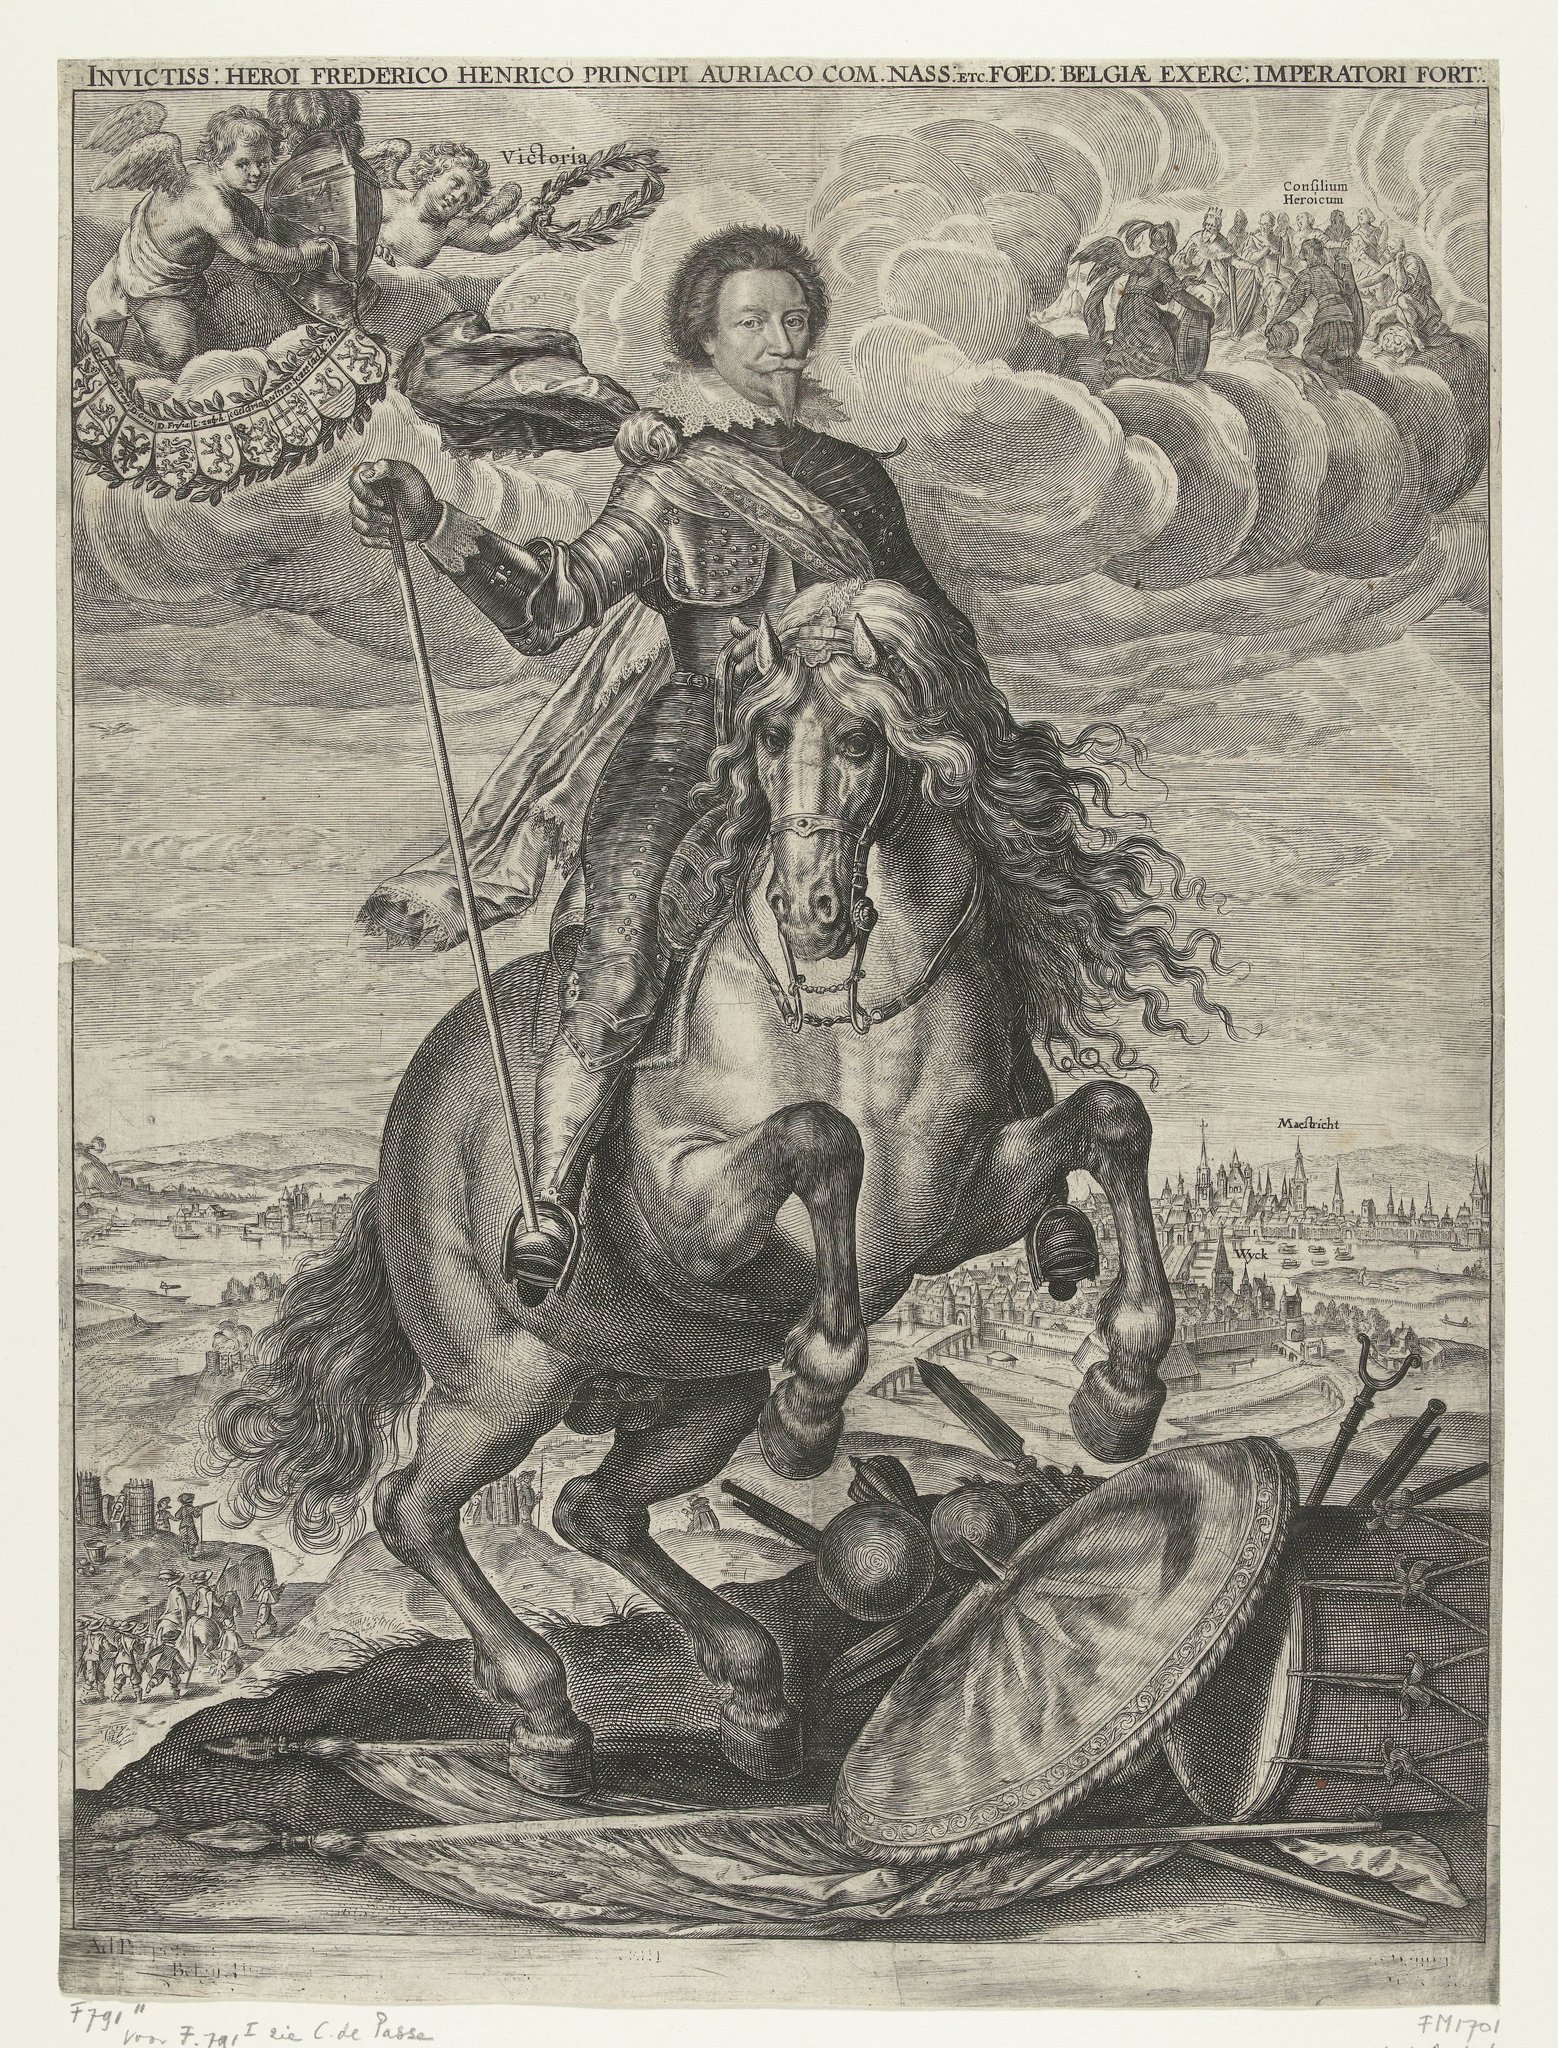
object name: propagandaprent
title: Invictiss: Heroi Frederico Henrico Principi Auriaco Com. Nass. etc. Foed. Belgiae Exerc. Imperatori Fort.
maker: crispijn van de passe (i)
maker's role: draughtsman, print maker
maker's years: 1564-1637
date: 1632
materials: paper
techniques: engraving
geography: northern netherlands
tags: frederick henry (prince of orange), maastricht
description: Allegorisch ruiterportret van Frederik Hendrik na de verovering van Maastricht, augustus 1632. De stadhouder op een steigerend paard, voor de voeten wapentuig. In de lucht links twee engelen met helm, krans met provinciewapens en lauwerkrans. Rechts het heldenberaad. Op de achtergrond de stad Maastricht. In de marge zijn nog sporen van de weggepolijste inscriptie.